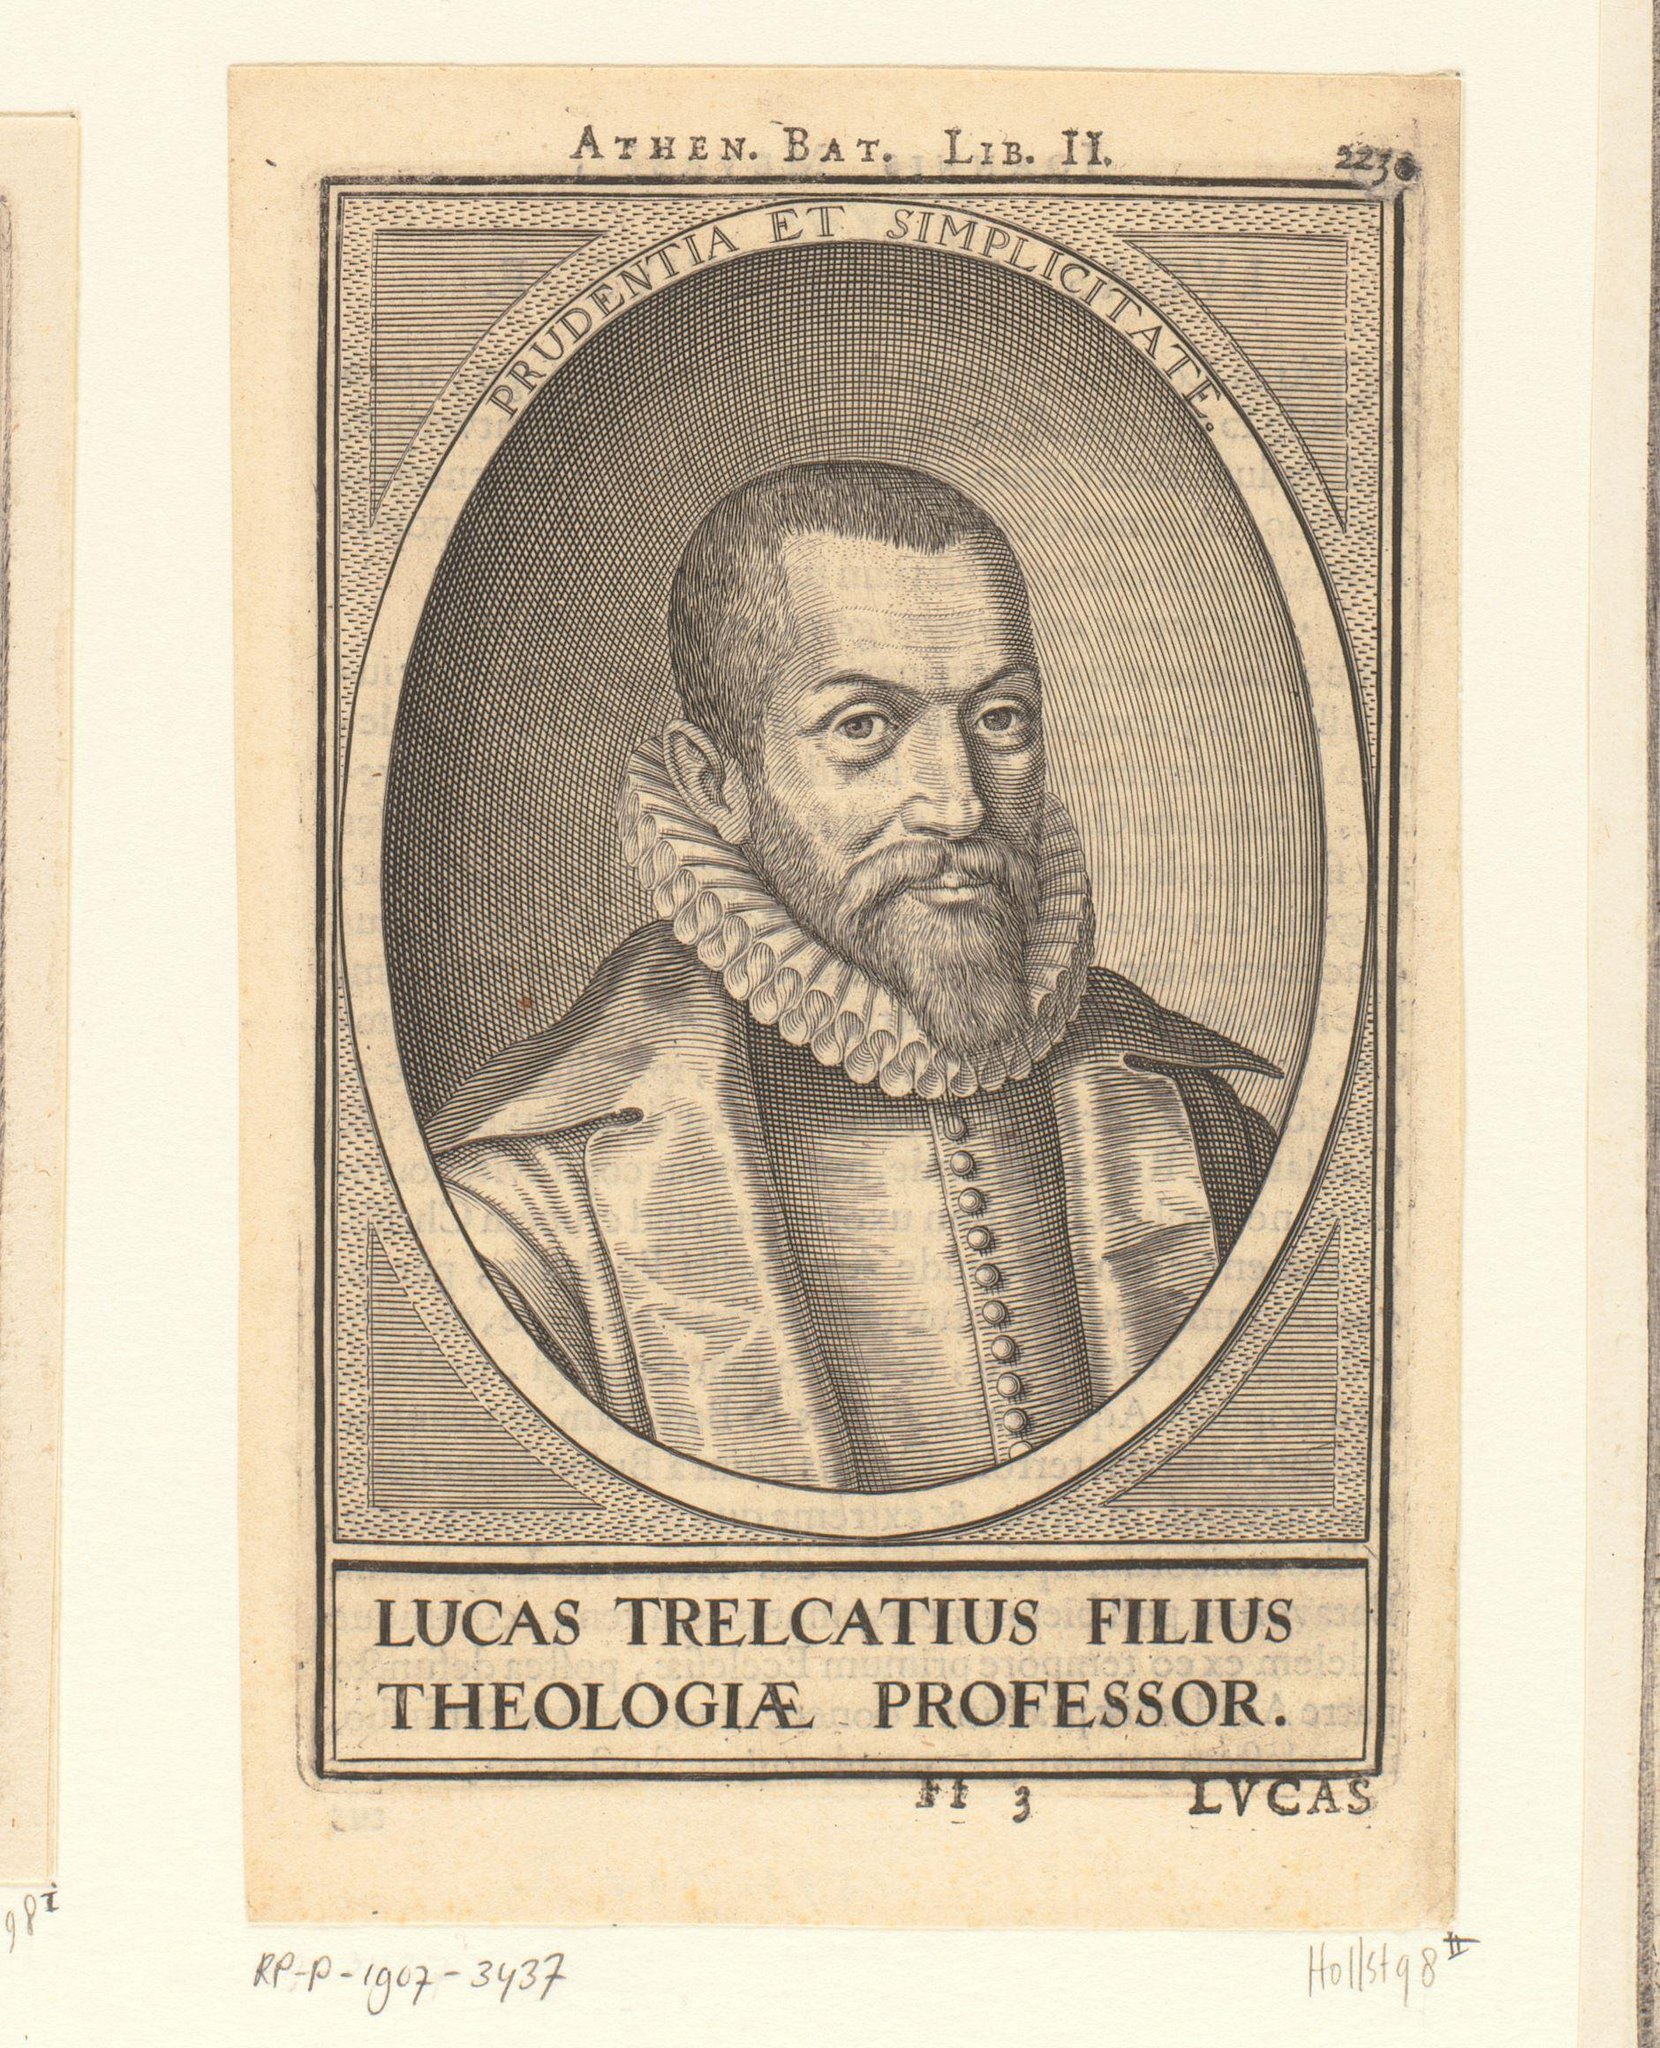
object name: print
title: Portret van Lucas Trelcatius (II)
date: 1609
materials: paper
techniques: engraving, letterpress printing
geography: leiden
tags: london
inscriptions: collector's mark: Lugt 2228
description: Prent uit: Icones ad vivum delineatæ et expressæ, virorvm clariorvm qui præcipue scriptis Academiam Lvgdvno Batavam illustrarunt. Leiden: Andries Clouck, 1609.